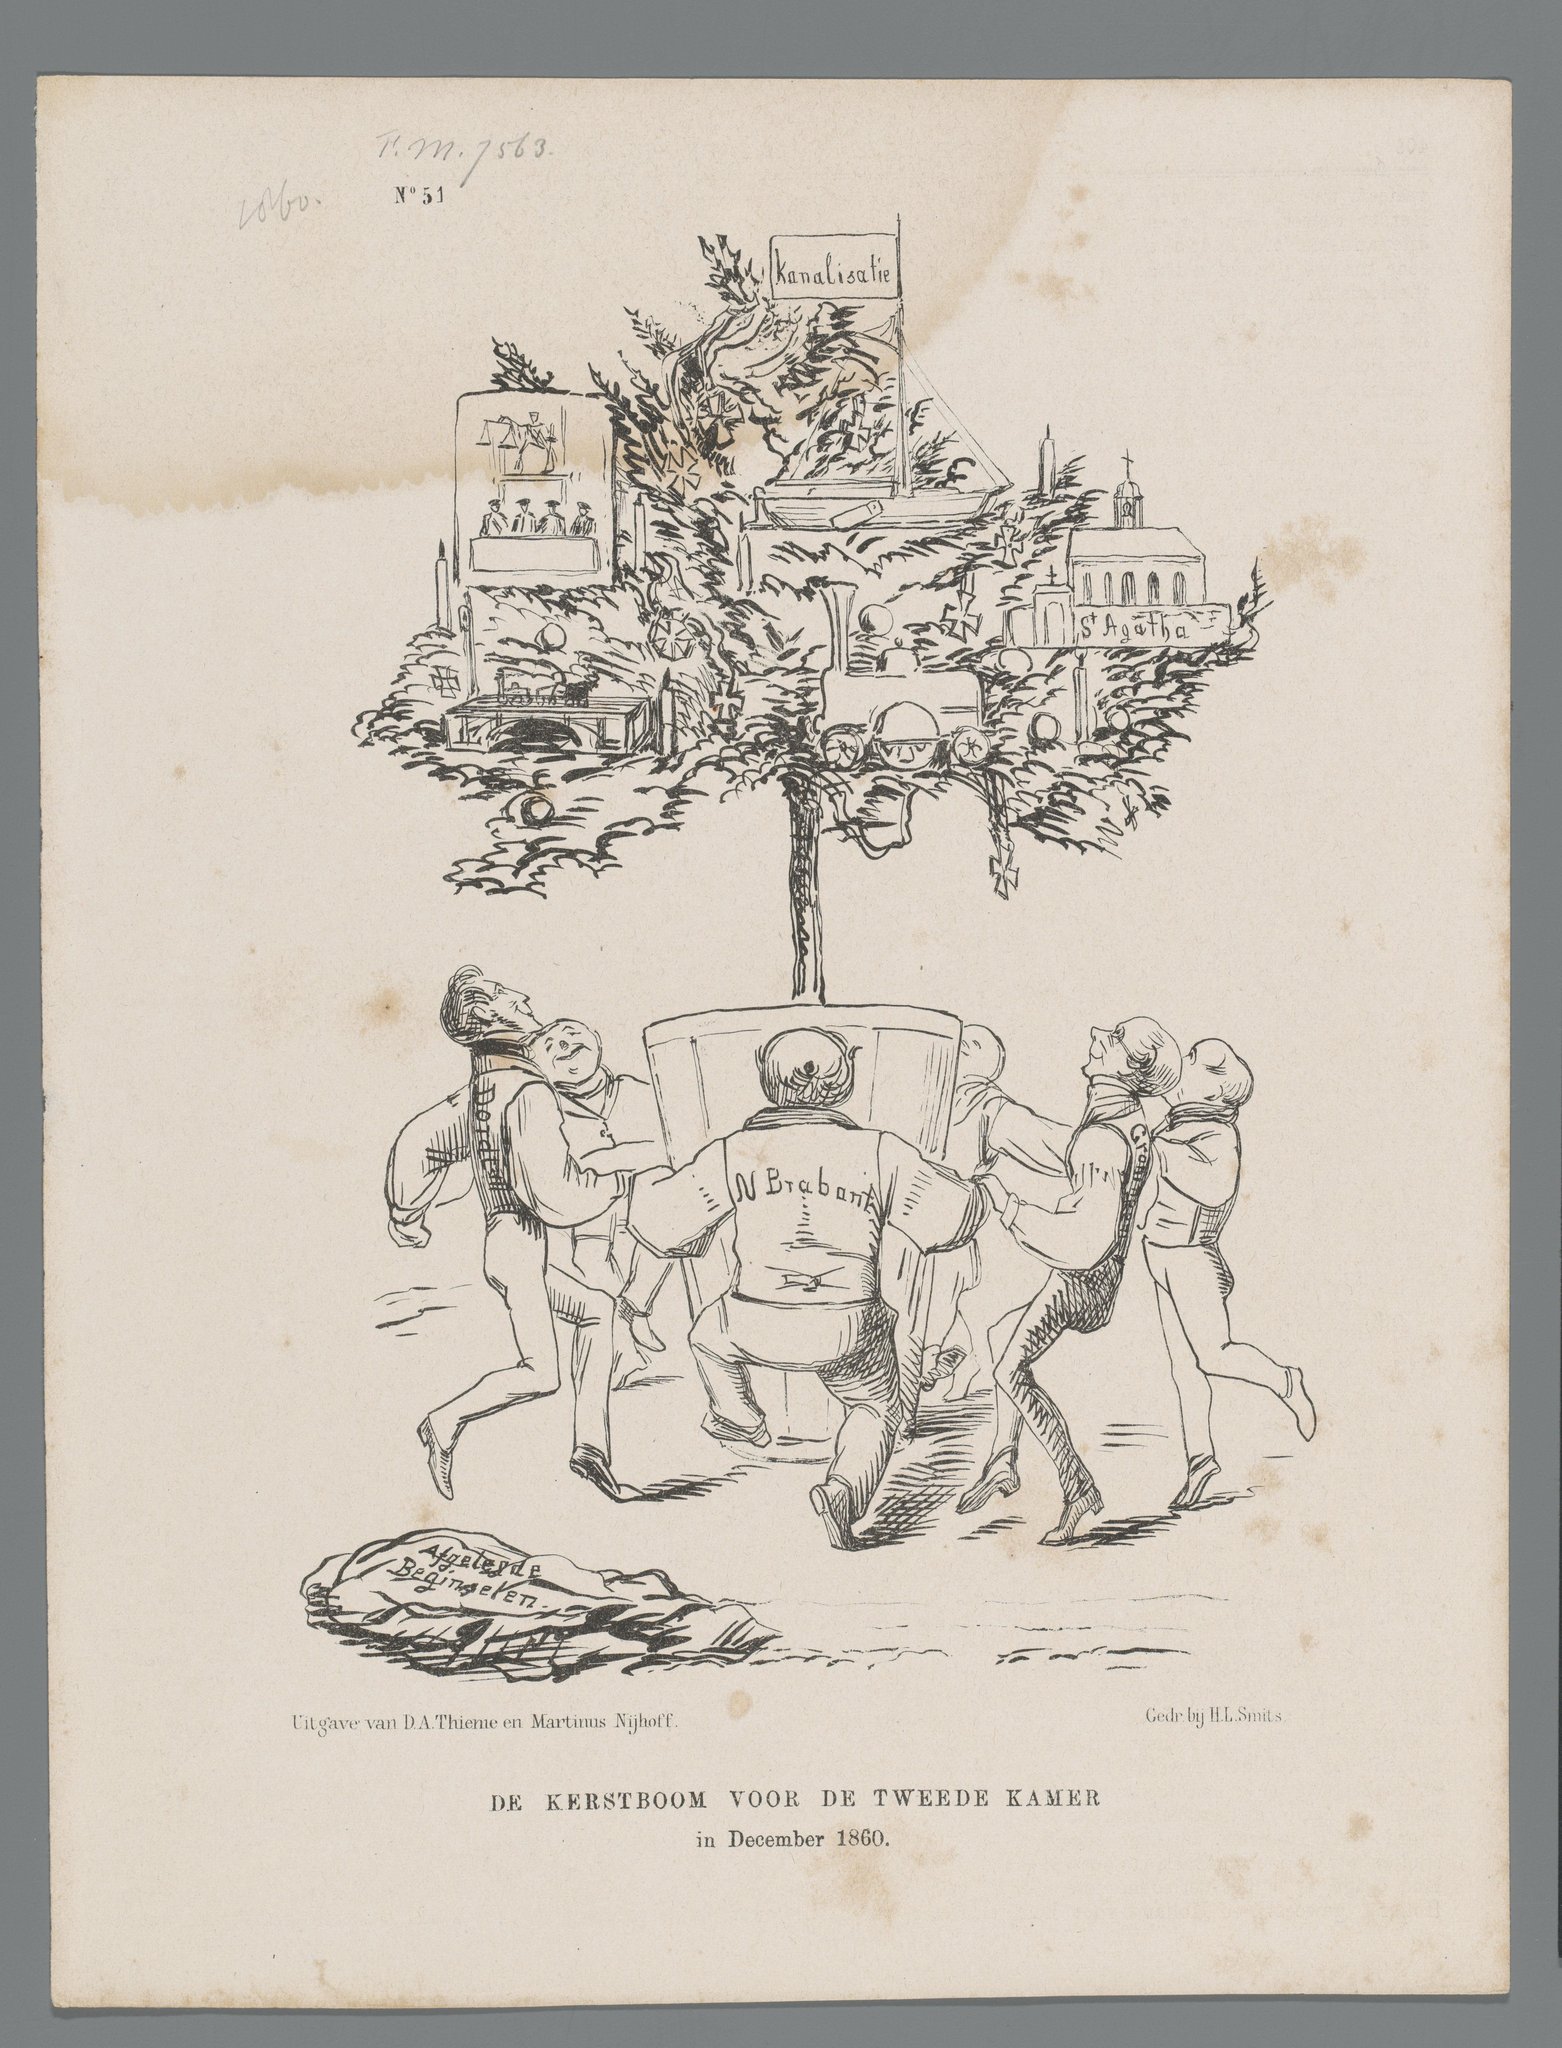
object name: print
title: Spotprent op de kerstboom voor de Tweede Kamer, 1860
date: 1860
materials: paper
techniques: lithograph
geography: arnhem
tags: christmas tree, group dancing around someone or something (folk dancing)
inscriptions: collector's mark: Lugt 2228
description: Spotprent op de kerstboom voor de Tweede Kamer, december 1860. Vertegenwoordigers van Noord-Brabant, Dordrecht en Groningen dansen om de boom versierd met geschenken als een klooster, een rechtbank, een locomotief en een kanaal. Plaat verschenen bij het weekblad De Nederlandsche Spectator, nr. 51, 22 december 1860.